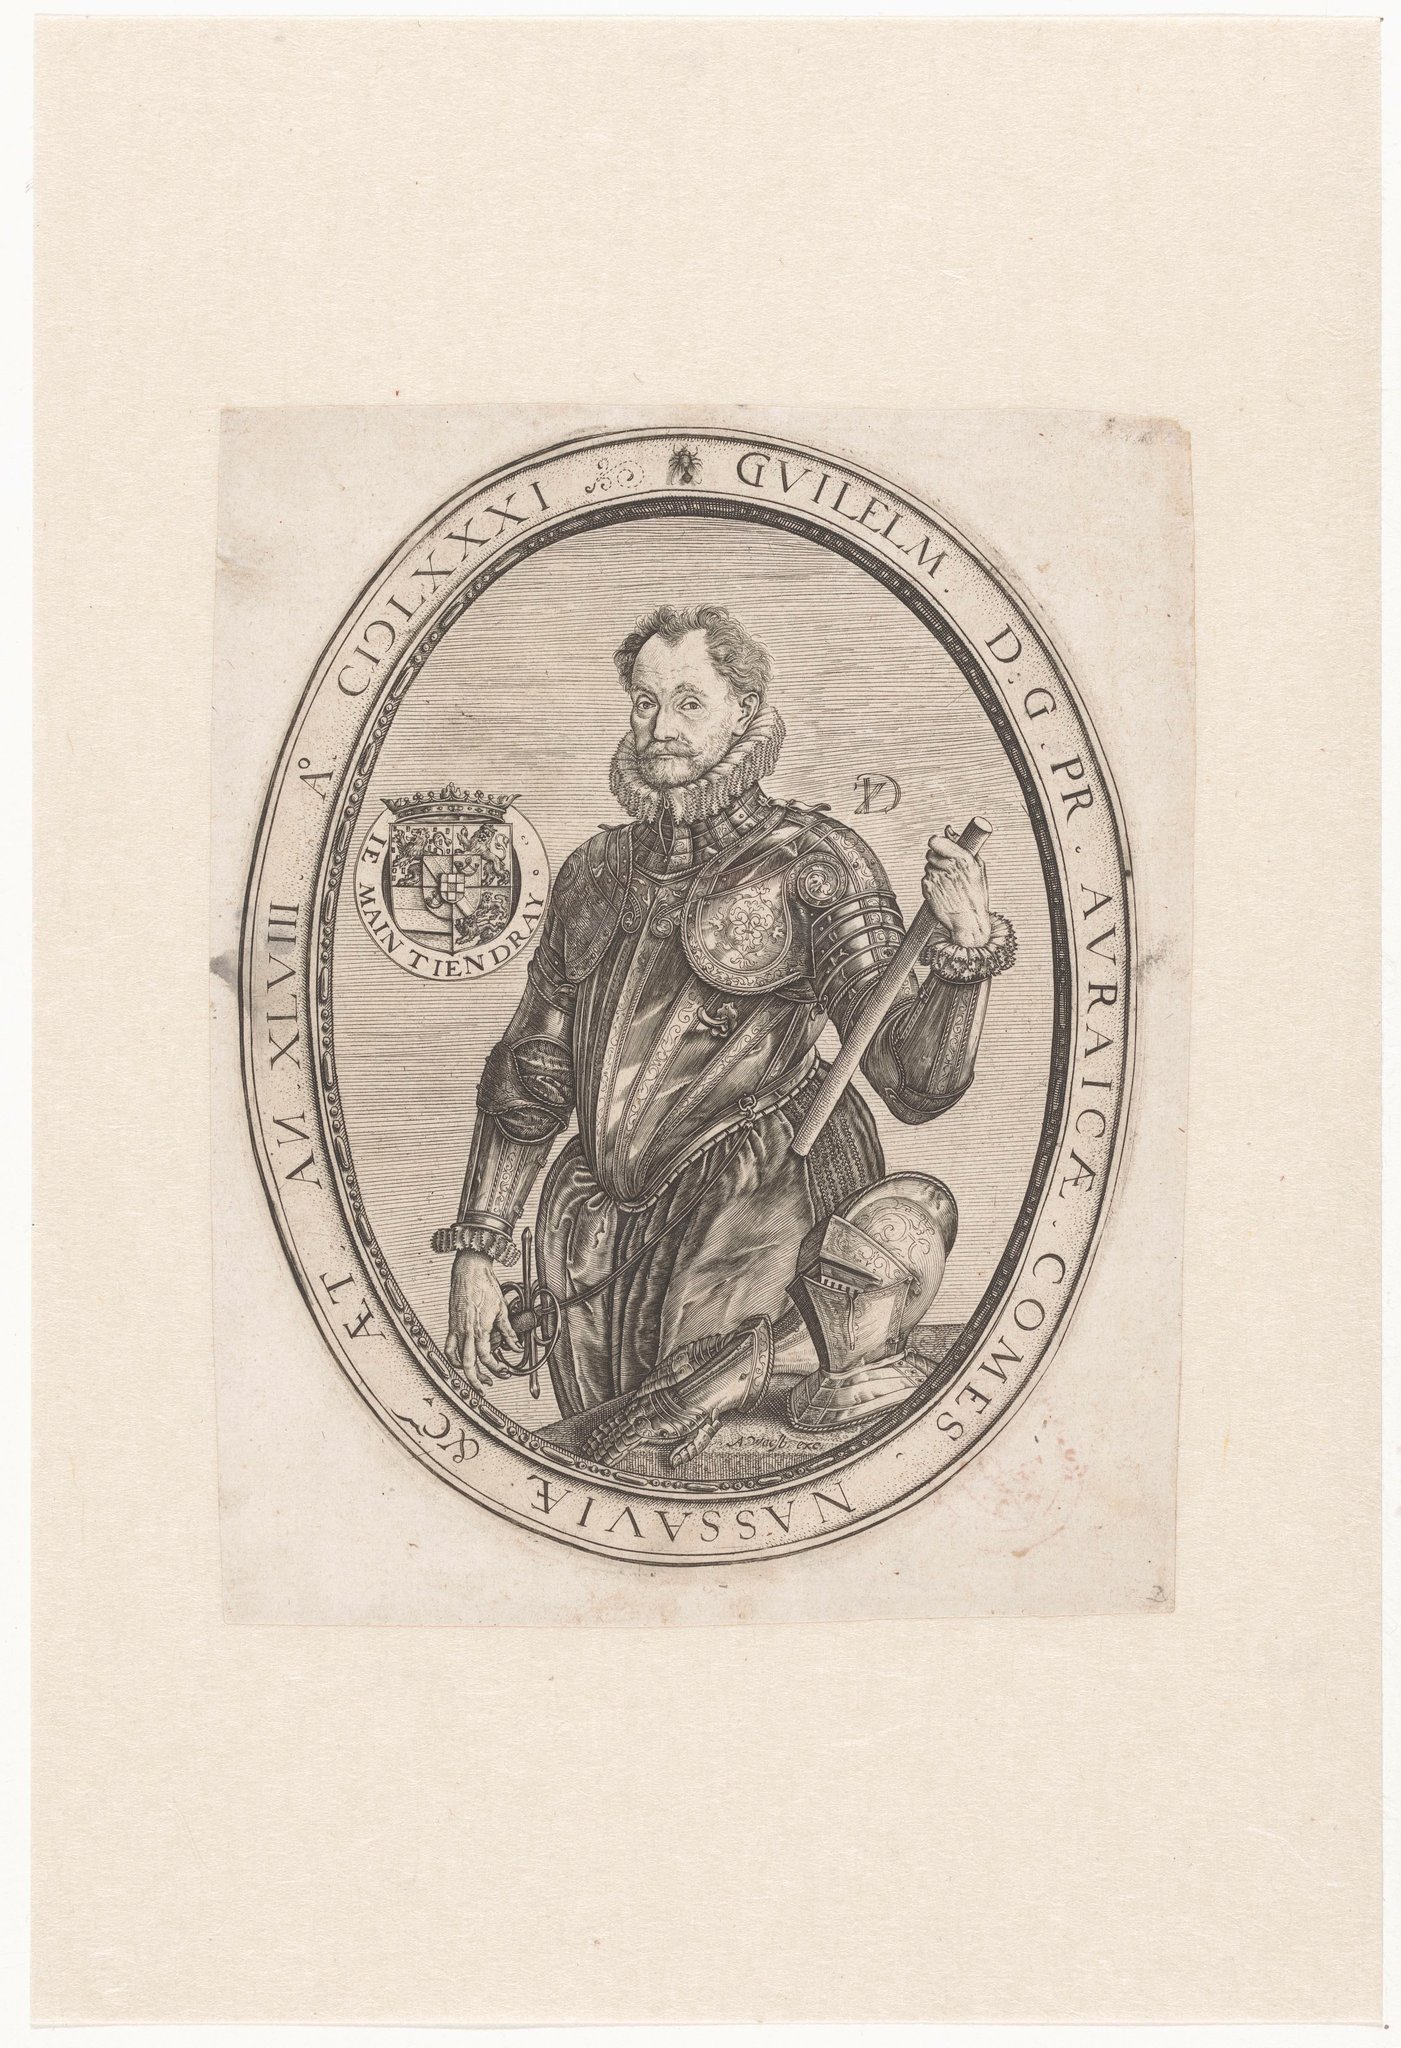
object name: print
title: Portret van Willem van Oranje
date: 1581-1601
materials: paper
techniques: engraving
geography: leiden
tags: delft, william i (prince of orange)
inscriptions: collector's mark: Lugt 240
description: Portret van Willem van Oranje op 47-jarige leeftijd, in ovaal met randschrift. Links zijn wapen met zijn lijfspreuk.